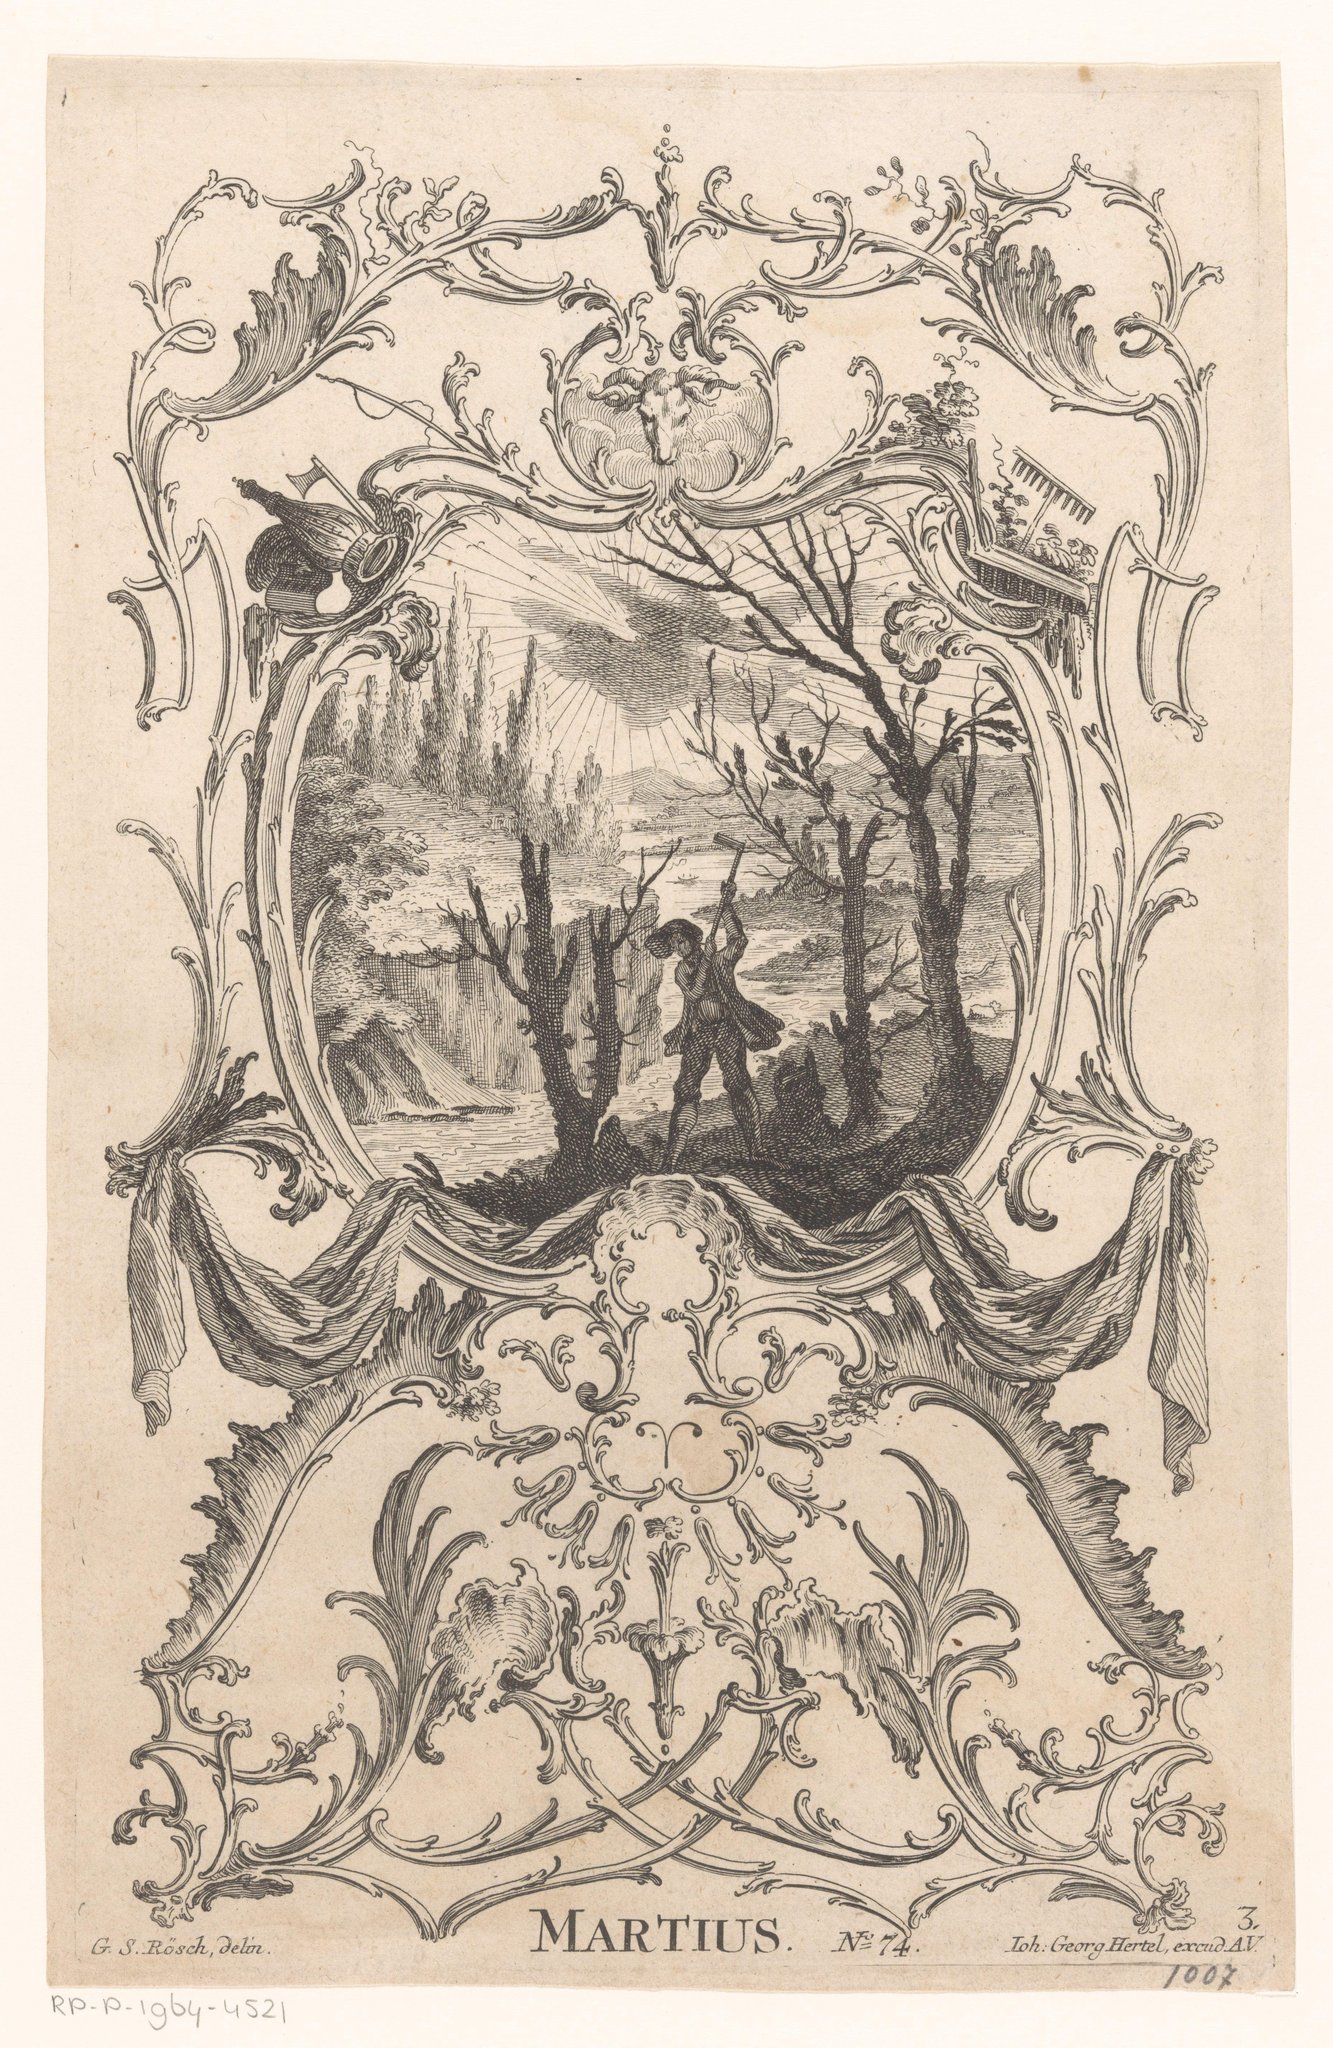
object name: print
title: Eerste zes maanden van het jaar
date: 1705-1766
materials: paper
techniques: etching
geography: augsburg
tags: woodcutting, woodcutter ~ forestry, march and its 'labours'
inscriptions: collector's mark: Lugt 2228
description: In een rocaille cartouche een houthakker in het bos. Rondom de voorstelling rocaille ornamenten, een ram en het bijbehorende teken van de dierenriem. Uitgeversnummer 74.